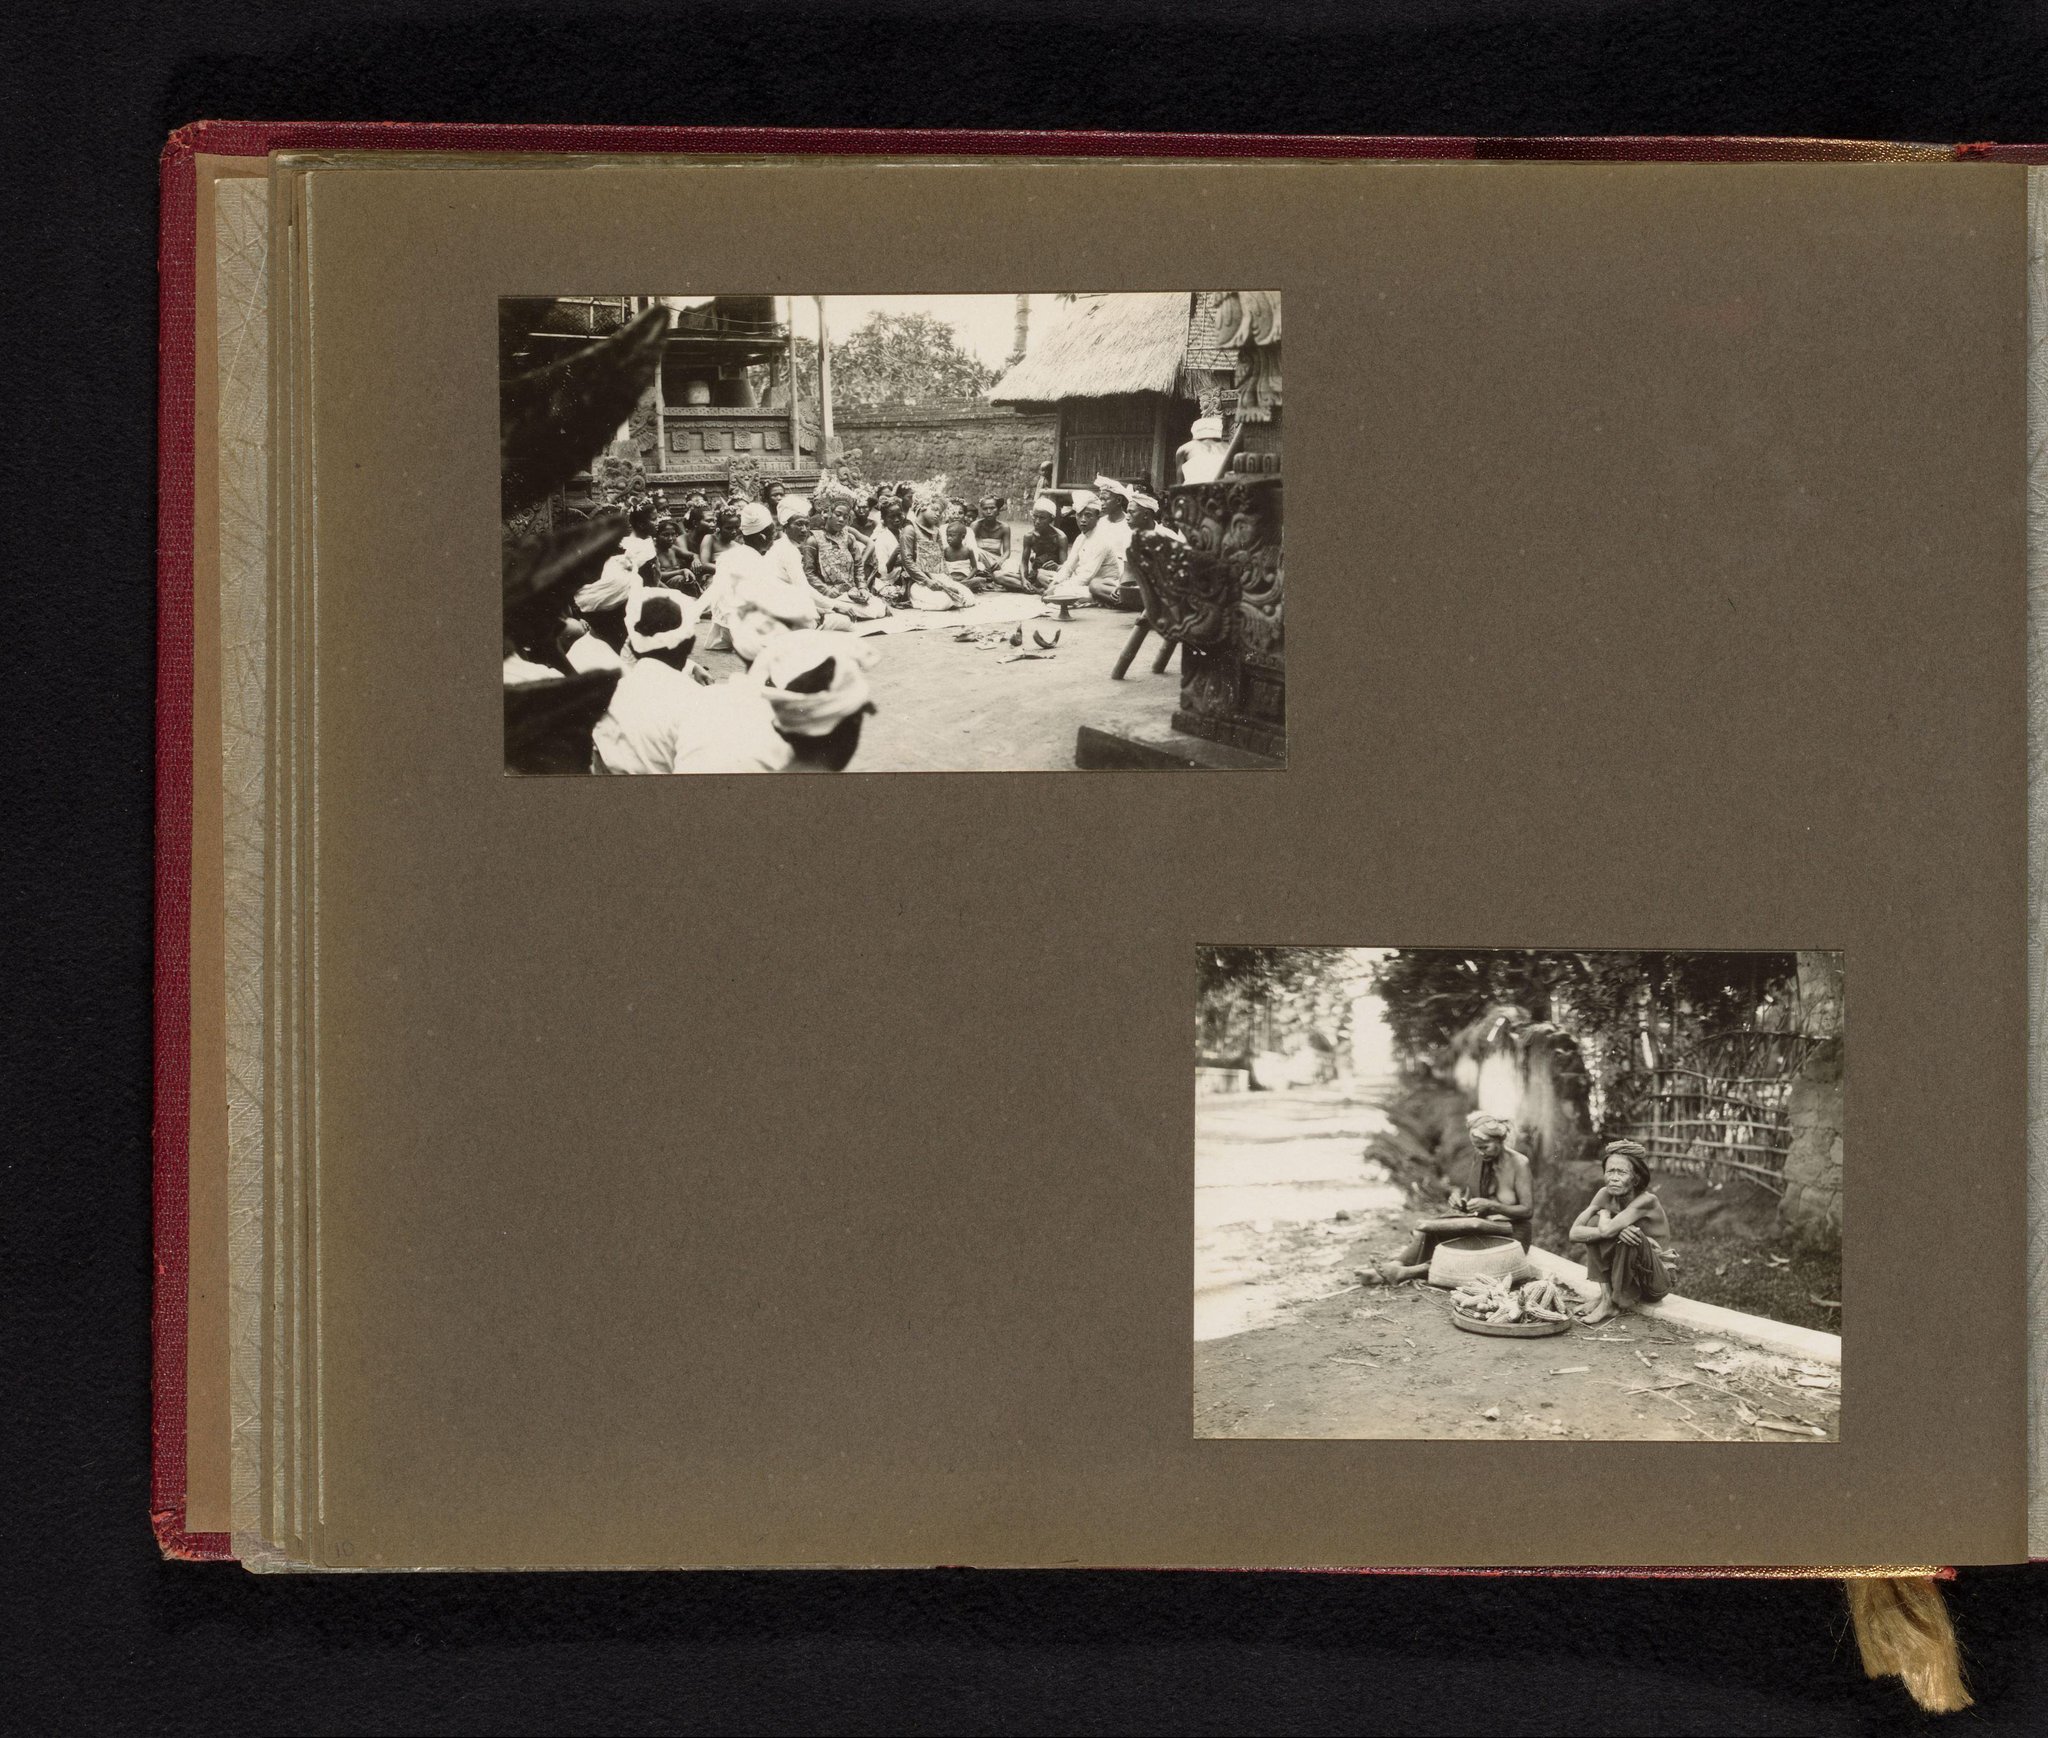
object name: photograph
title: Groep personen rondom een dans en Twee oudere vrouwen die mais verkopen langs een weg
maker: Anonymous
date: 1950-1960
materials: photographic support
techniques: gelatin silver print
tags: ritual practices ~ non-christian religions, old woman, cereal, grain, corn (grass with grains, grown for food, e.g.: wheat, rice, rye, oats, maize, buckwheat, millet), dutch east indies, the